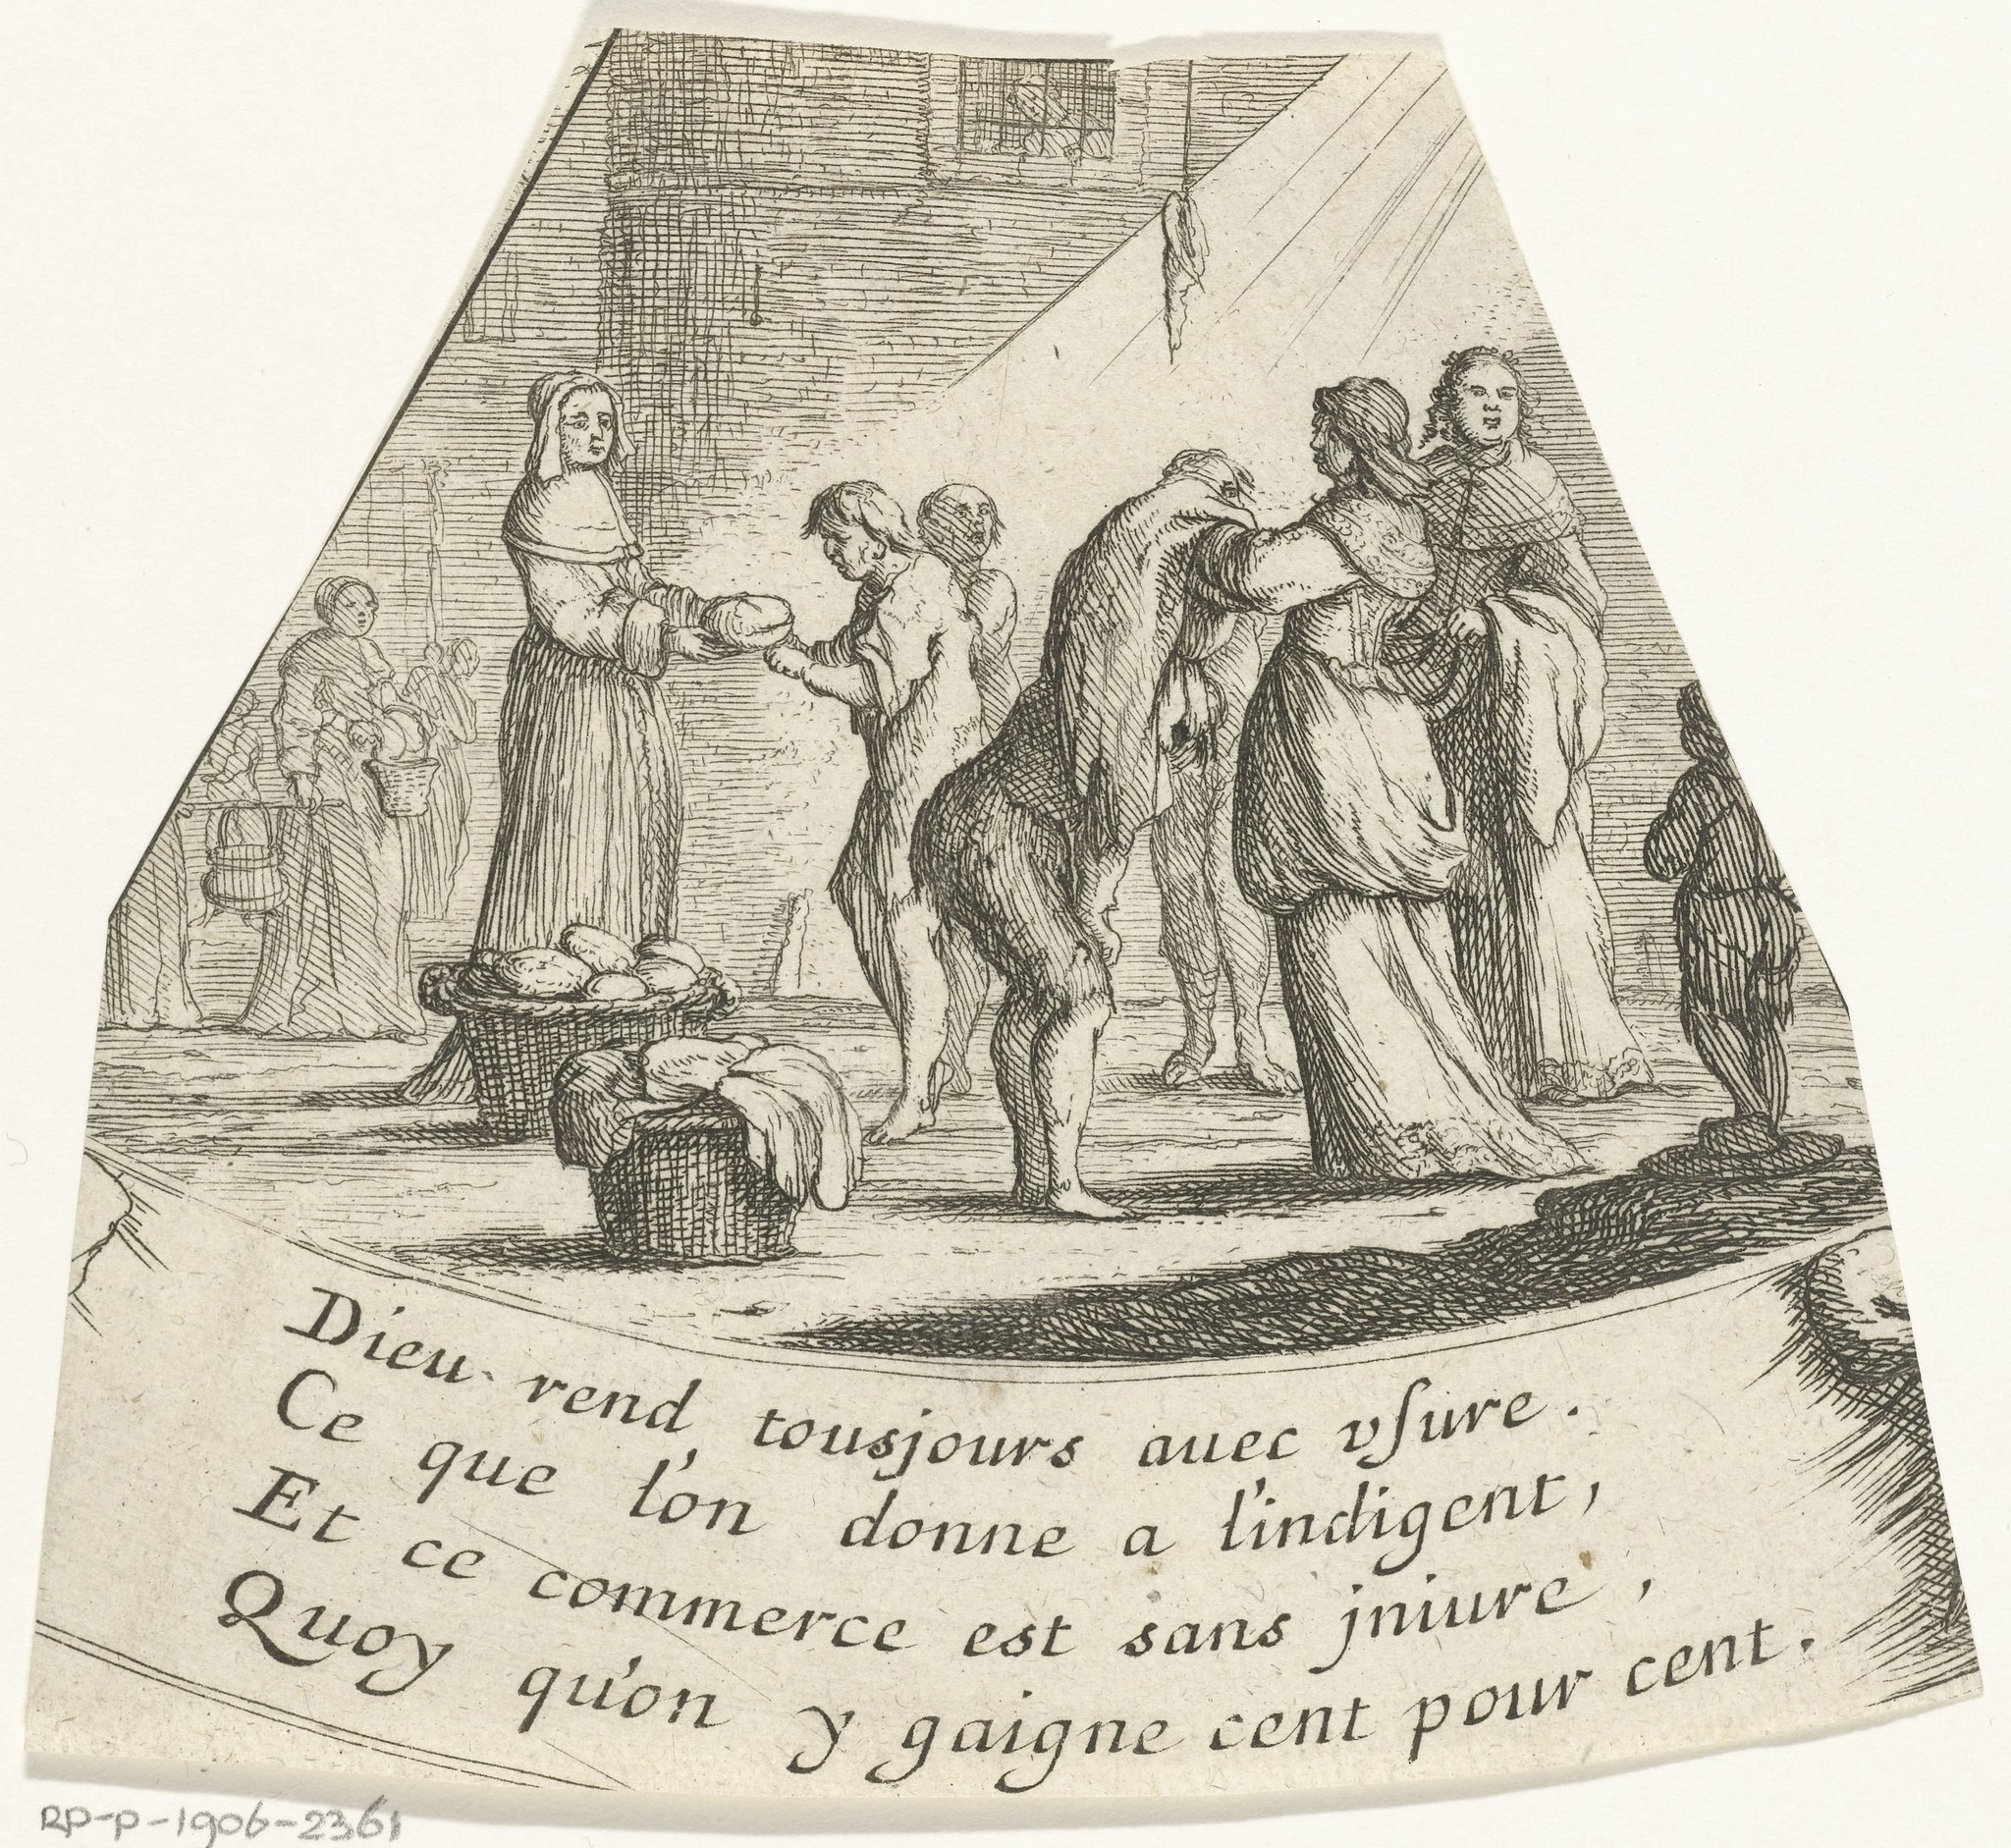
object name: print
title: Zeven werken van barmhartigheid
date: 1648-1665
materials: paper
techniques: etching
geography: paris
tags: feeding the hungry, 'esuriens cibatur' ~ one of the (seven) acts of mercy, clothing the naked, 'nudus vestitur' ~ one of the (seven) acts of mercy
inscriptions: collector's mark: Lugt 2228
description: Een vrouw helpt een bedelaar zijn vodden uit te trekken, terwijl een tweede vrouw klaar staat met nieuwe kleding. Een derde vrouw deelt broden uit. Onder de voorstelling een Frans vers van vier regels. Zeshoekig blad, waarschijnlijk onderdeel van een cirkelvormige prent.